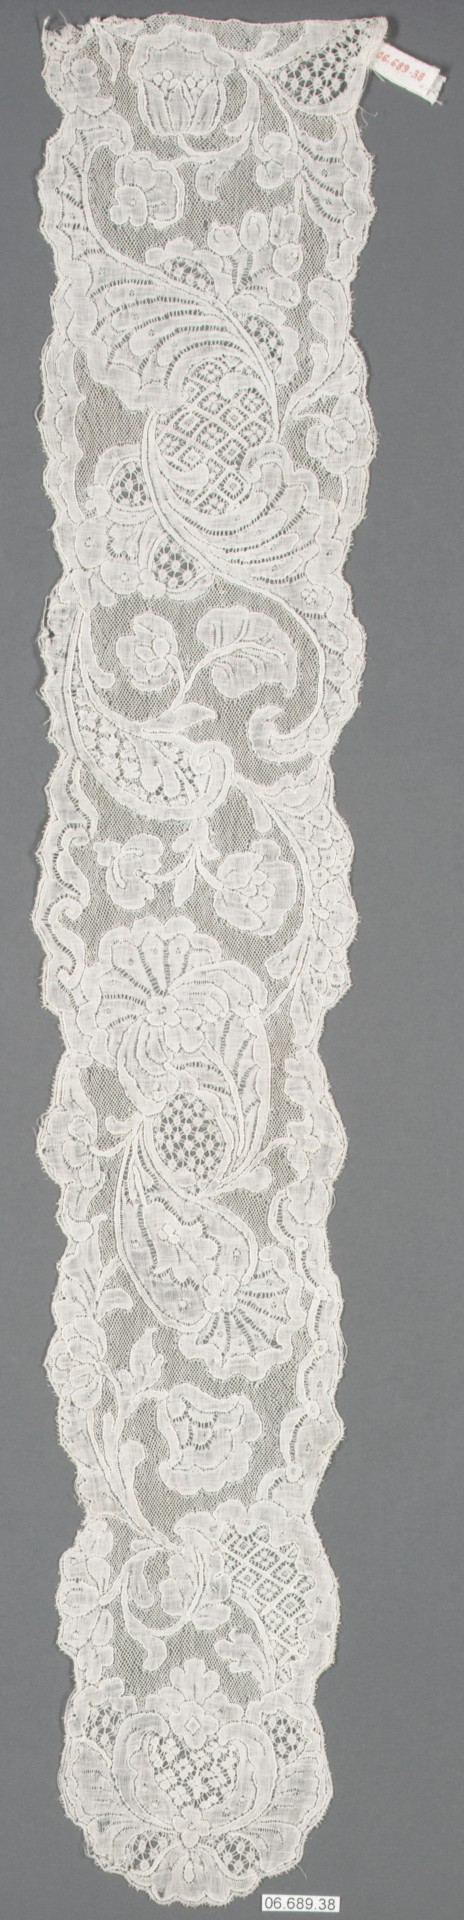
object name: lappet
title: Lappet (one of a pair)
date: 1701-1733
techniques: lace